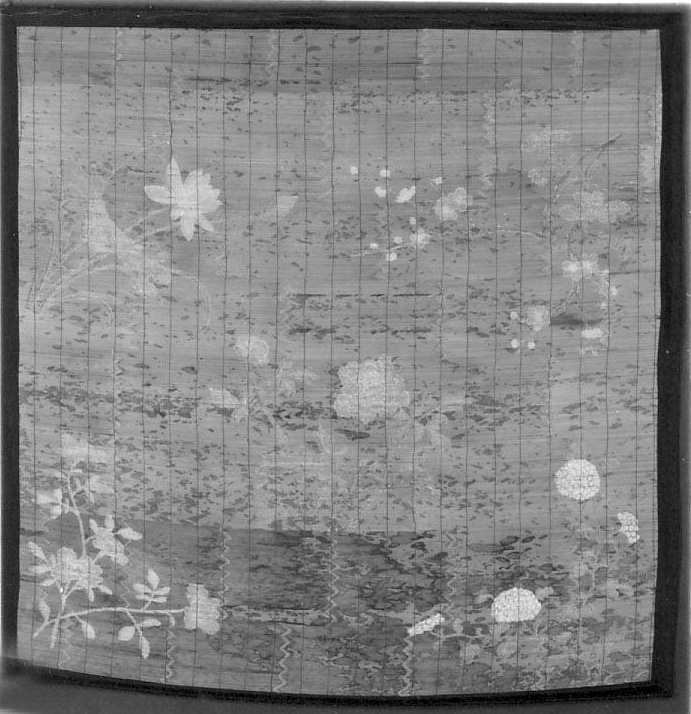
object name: blind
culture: chinese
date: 1701-1900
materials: bamboo, paint, silk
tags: flowers